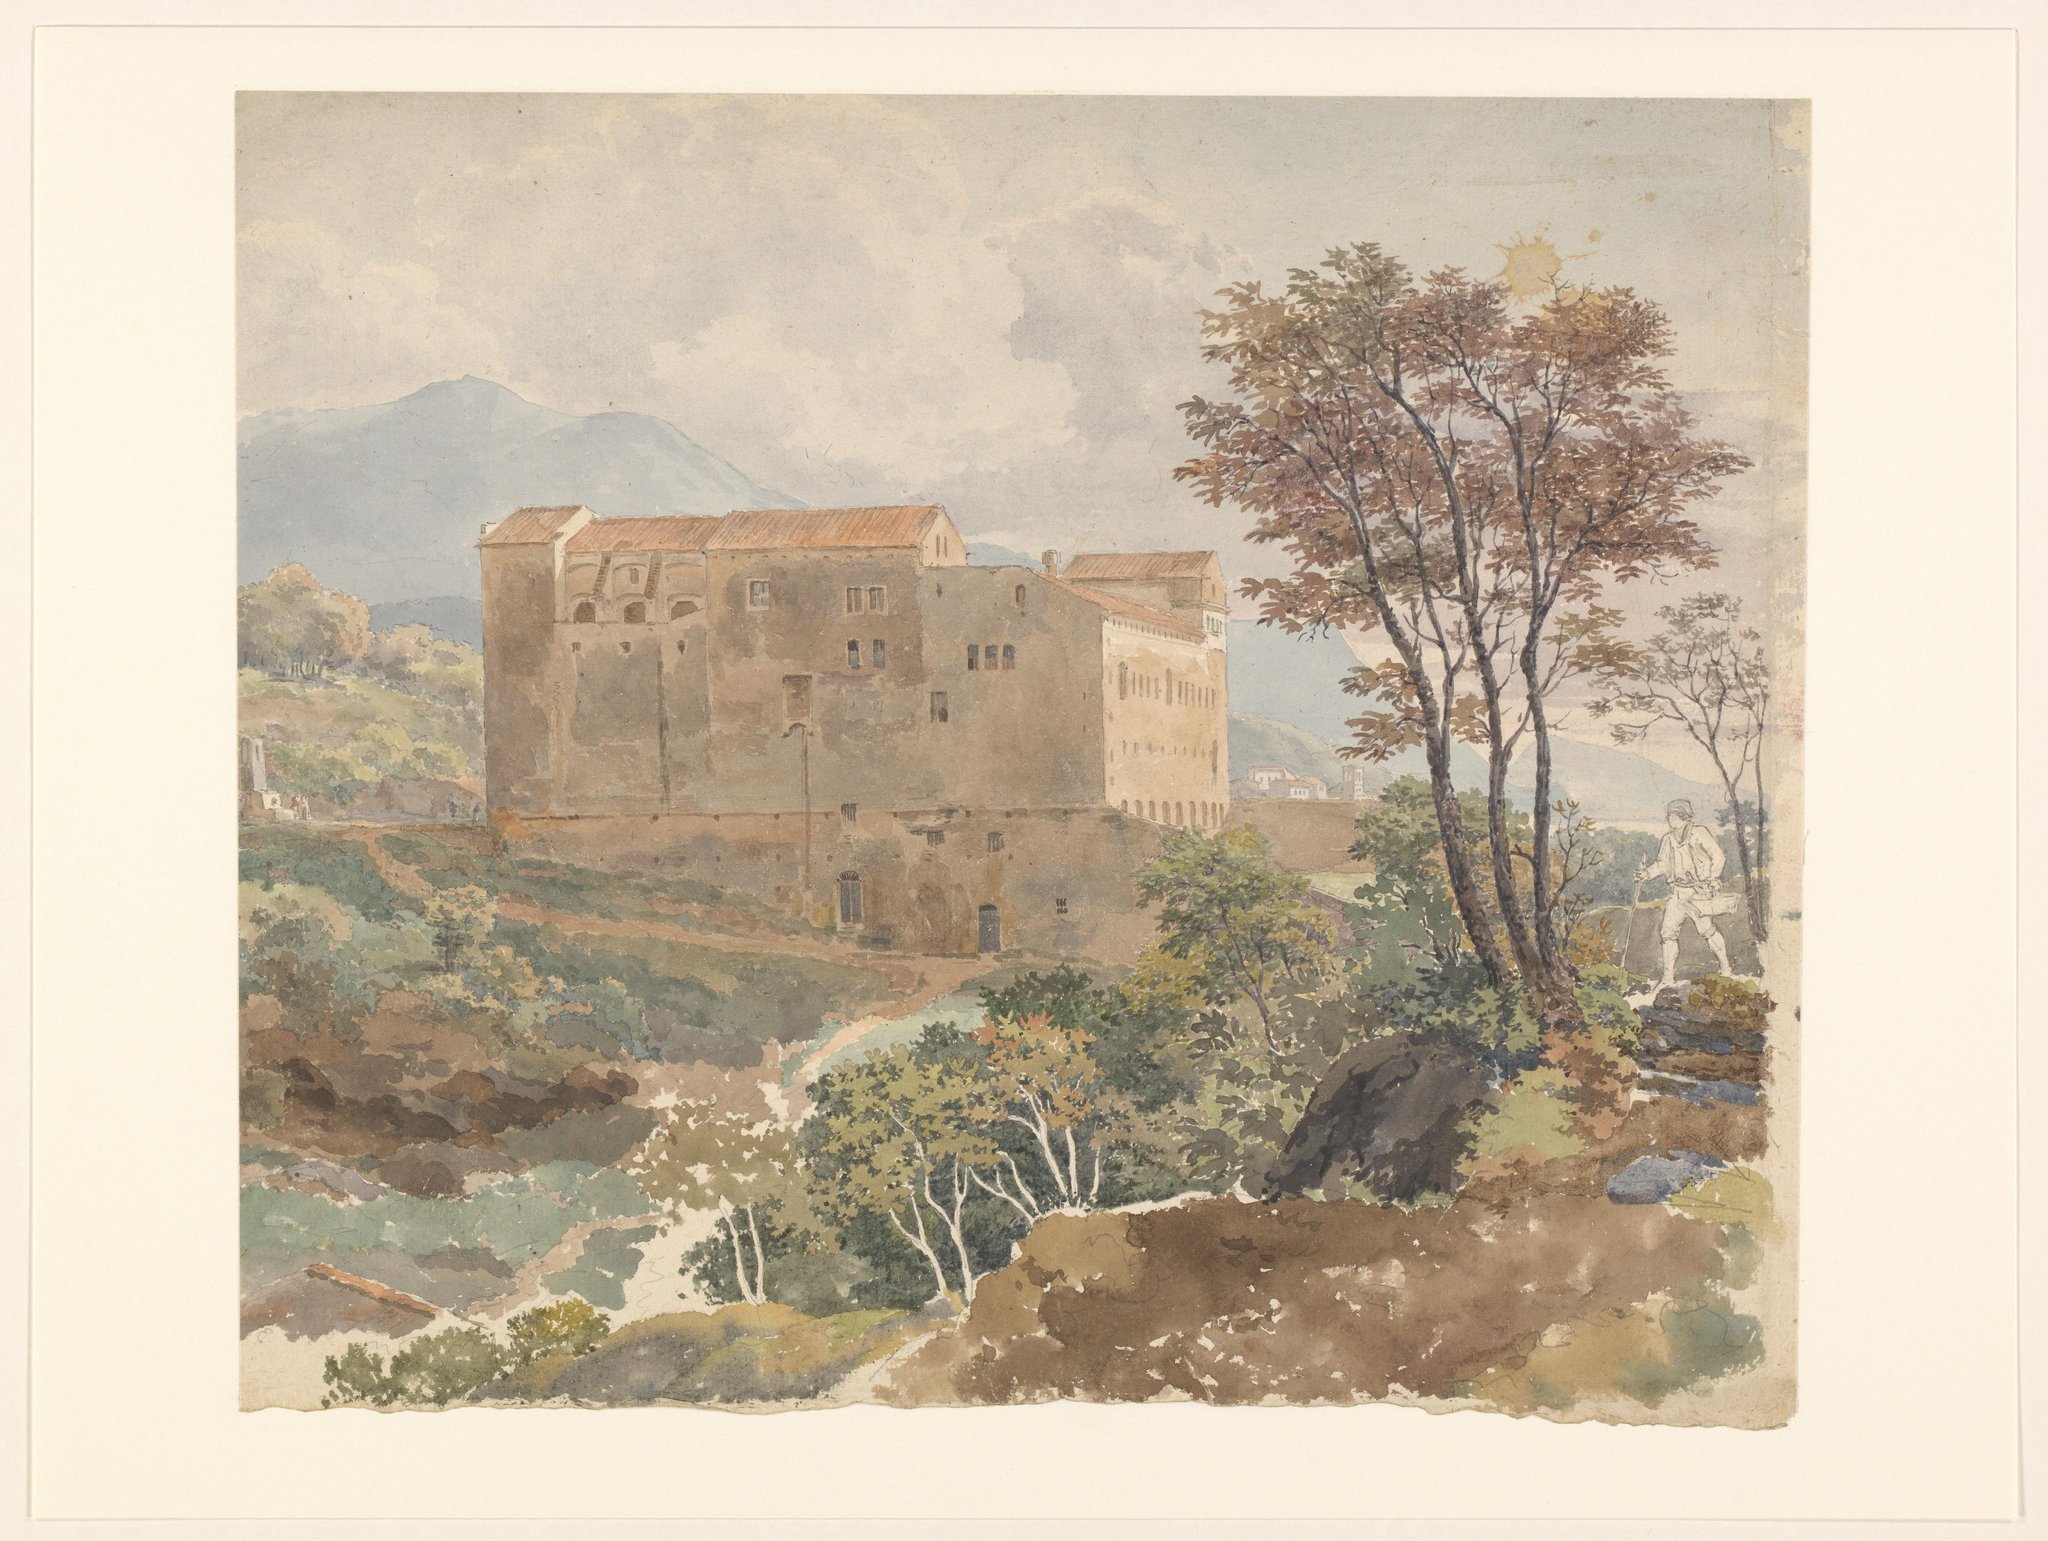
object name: drawing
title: Landschap bij Vietri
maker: henry swinburne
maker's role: draughtsman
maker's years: 1743-1803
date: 1753-1803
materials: paper, pencil, watercolor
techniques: brush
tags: farm or solitary house in landscape